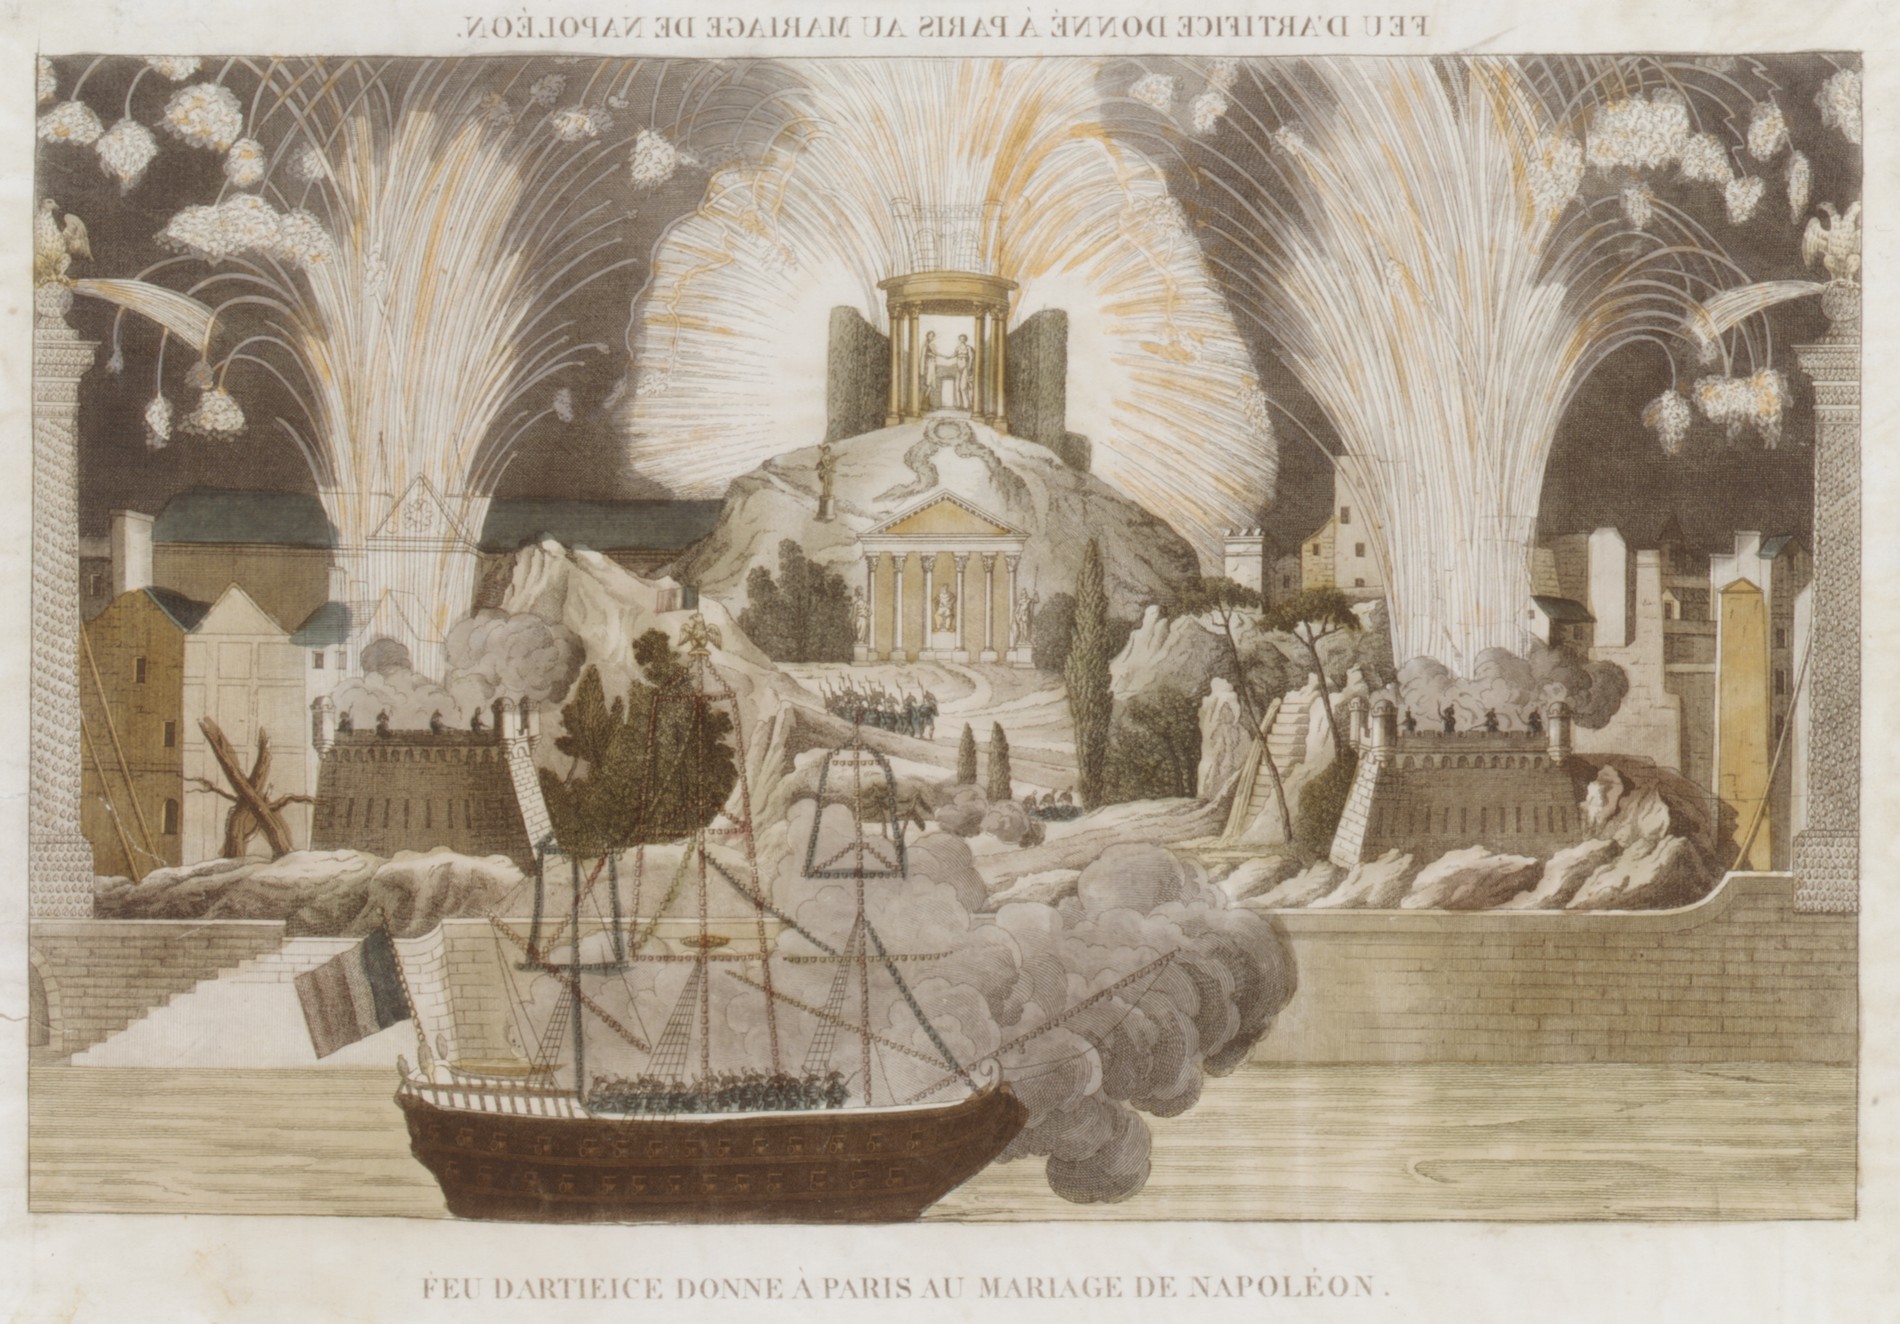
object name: print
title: Feu d'Artifice donné à Paris au Mariage de Napoléon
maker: anonymous, french, 19th century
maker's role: artist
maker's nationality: french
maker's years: 1800-1900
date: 1810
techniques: engraving, etching, hand coloring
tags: palaces,fireworks,ships